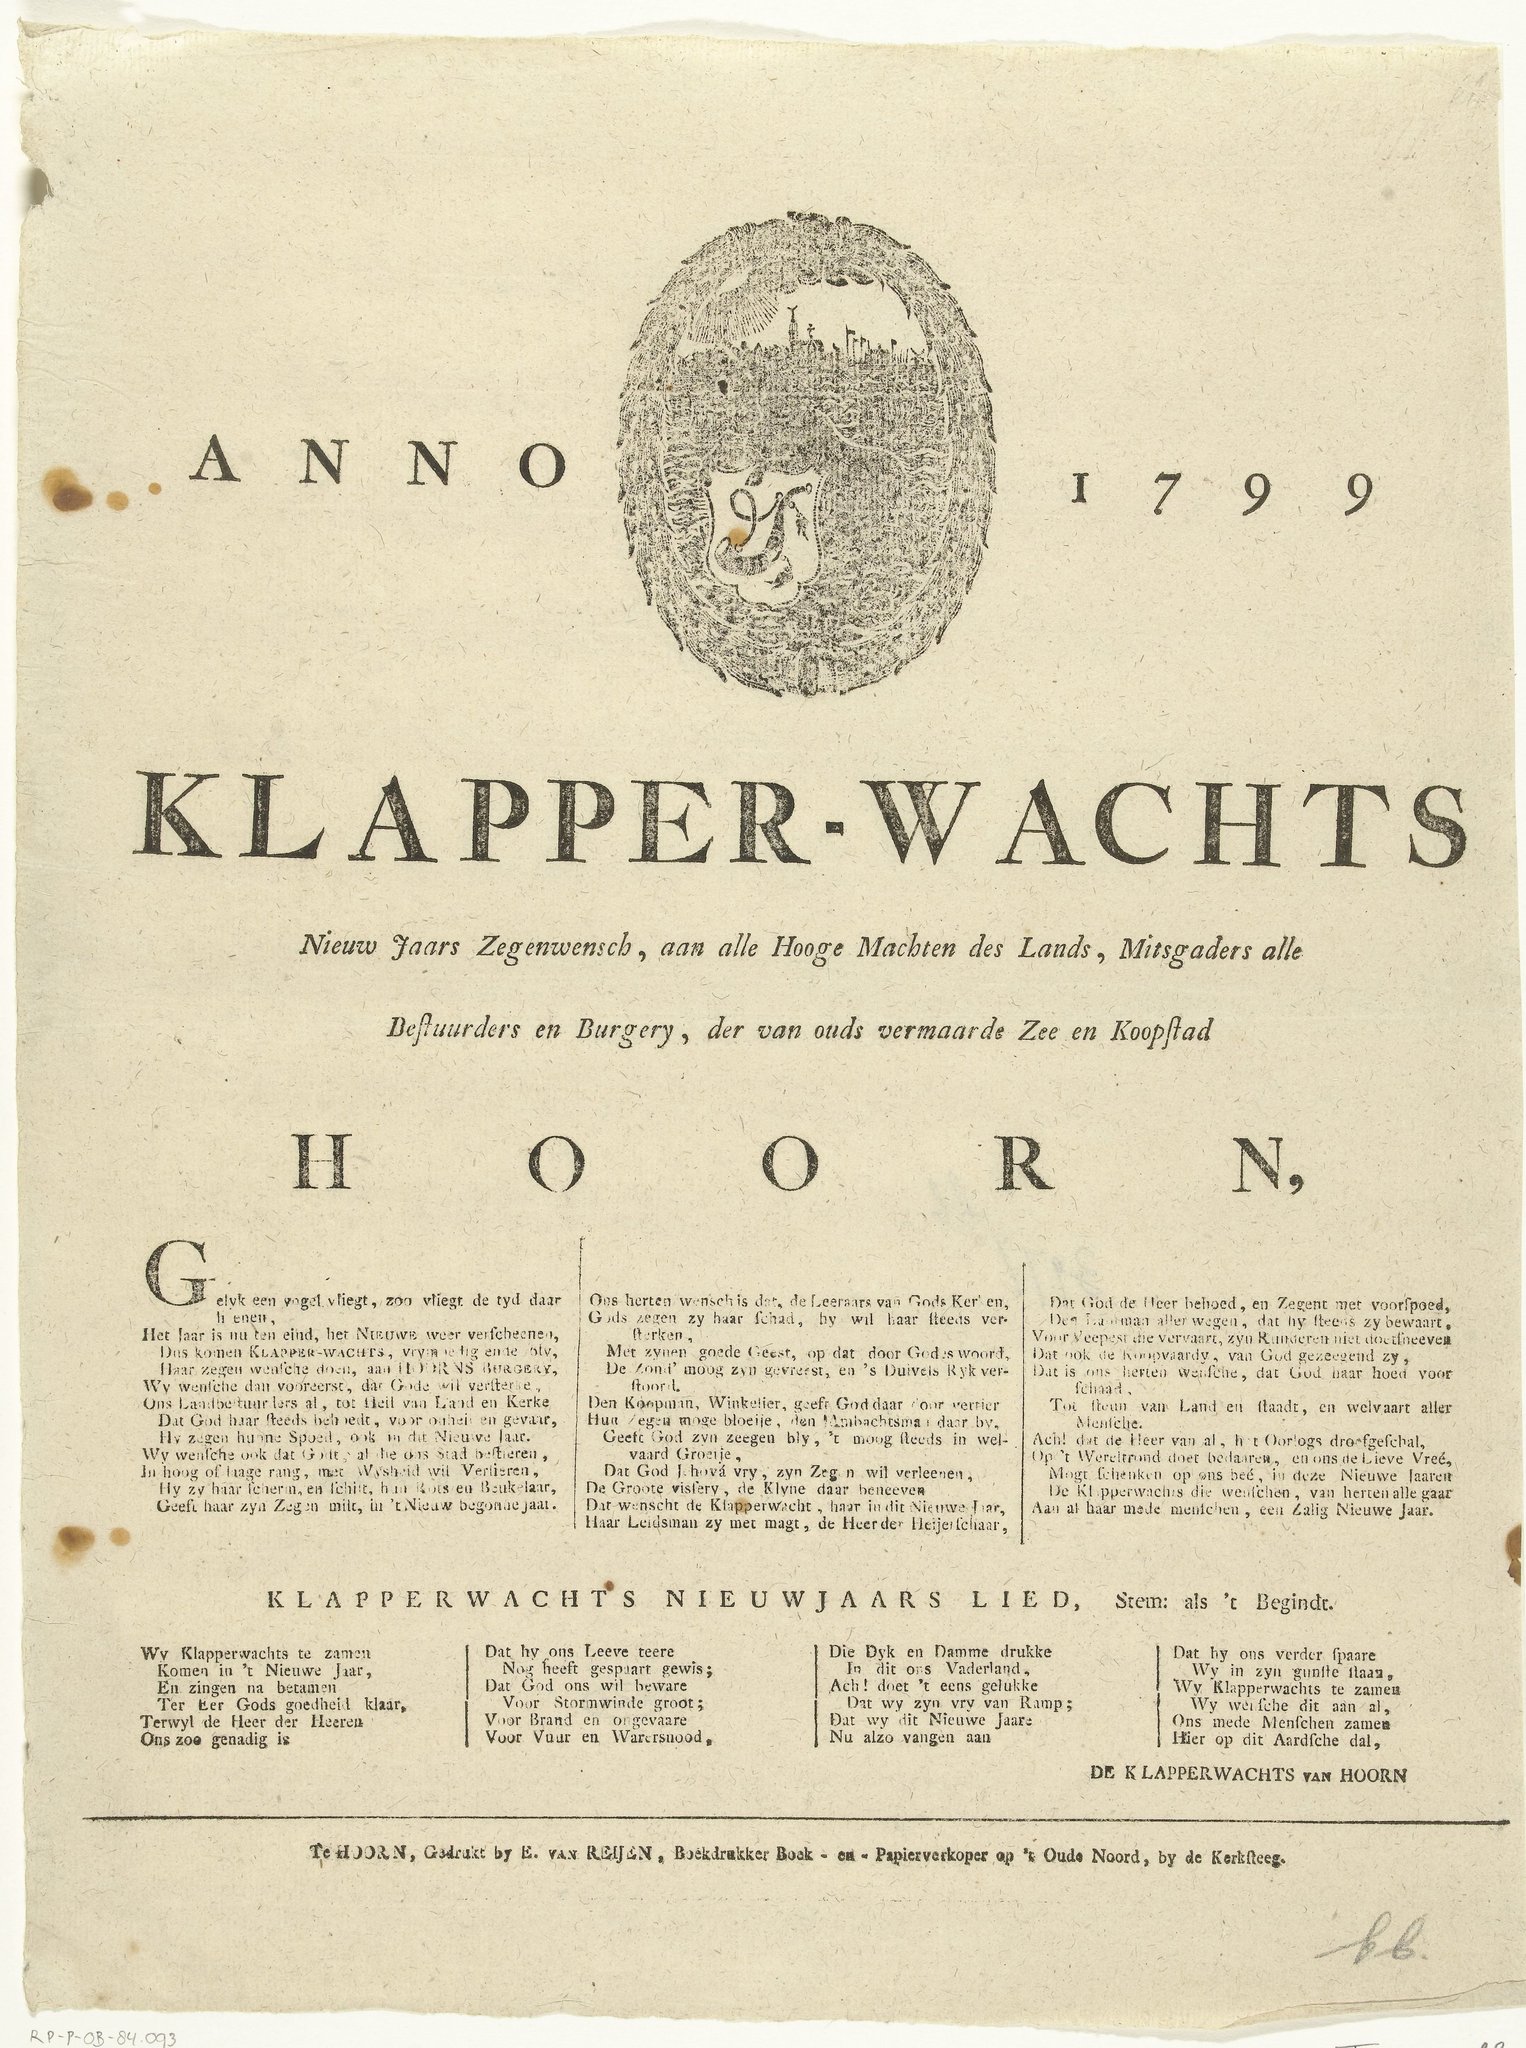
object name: print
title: Nieuwjaarsprent van de Hoornse klapperwacht voor het jaar 1799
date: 1796-1797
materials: paper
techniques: letterpress printing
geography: hoorn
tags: hoorn (north holland)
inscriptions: collector's mark: Lugt 2228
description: Nieuwjaarsprent van de klapperwacht (nachtwacht) van de stad Hoorn voor het jaar 1799. Opgedragen aan de bestuurders en inwoners van Hoorn. Omkranst vignet met een eenhoorn met het wapen van Hoorn op het water voor de haven, boven een vers in drie kolommen en een lied in vier verzen.